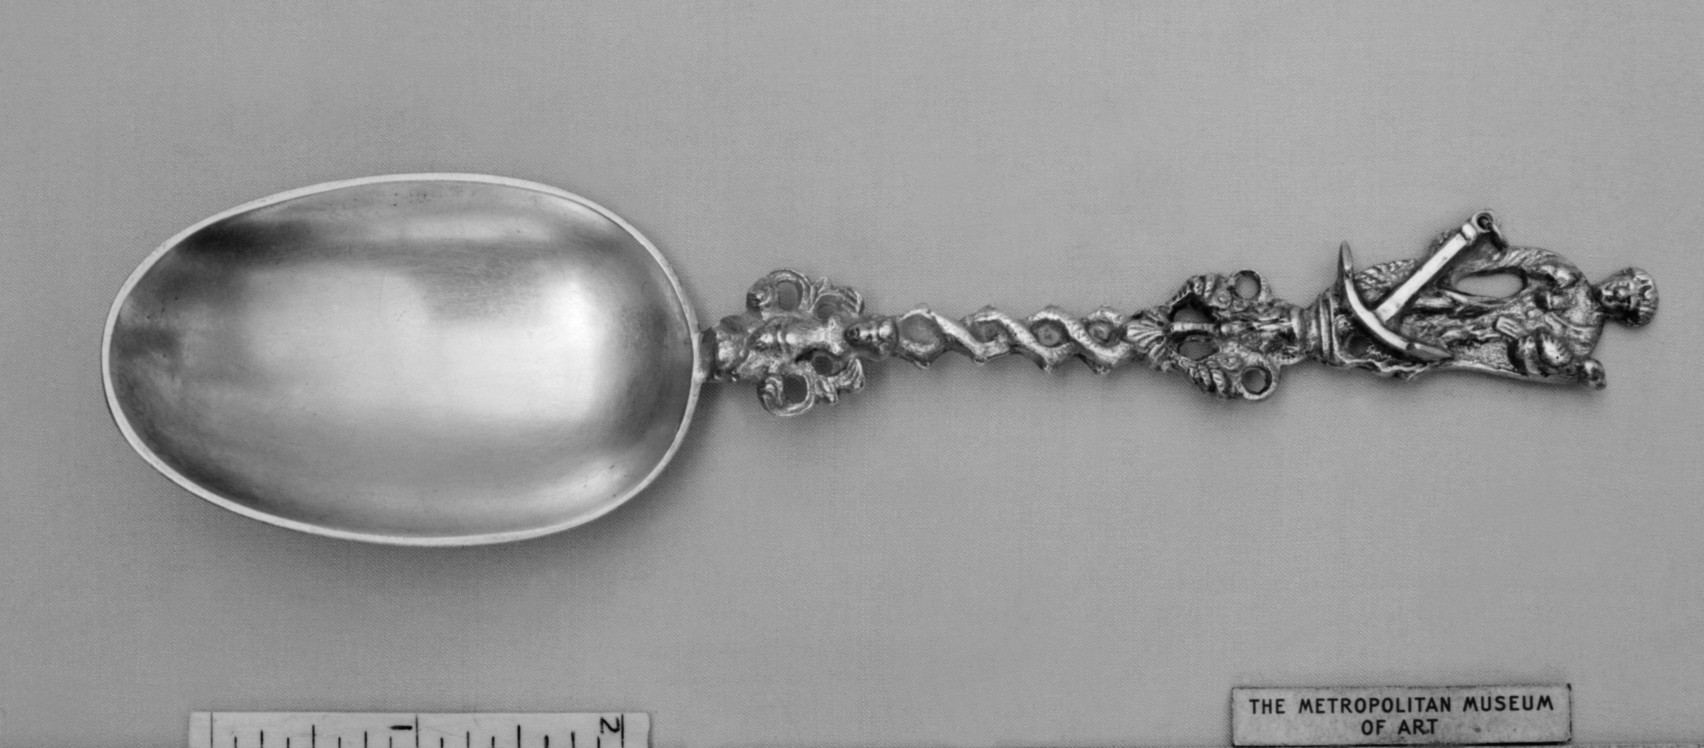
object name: spoon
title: Figure-top spoon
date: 1851-1900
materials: silver